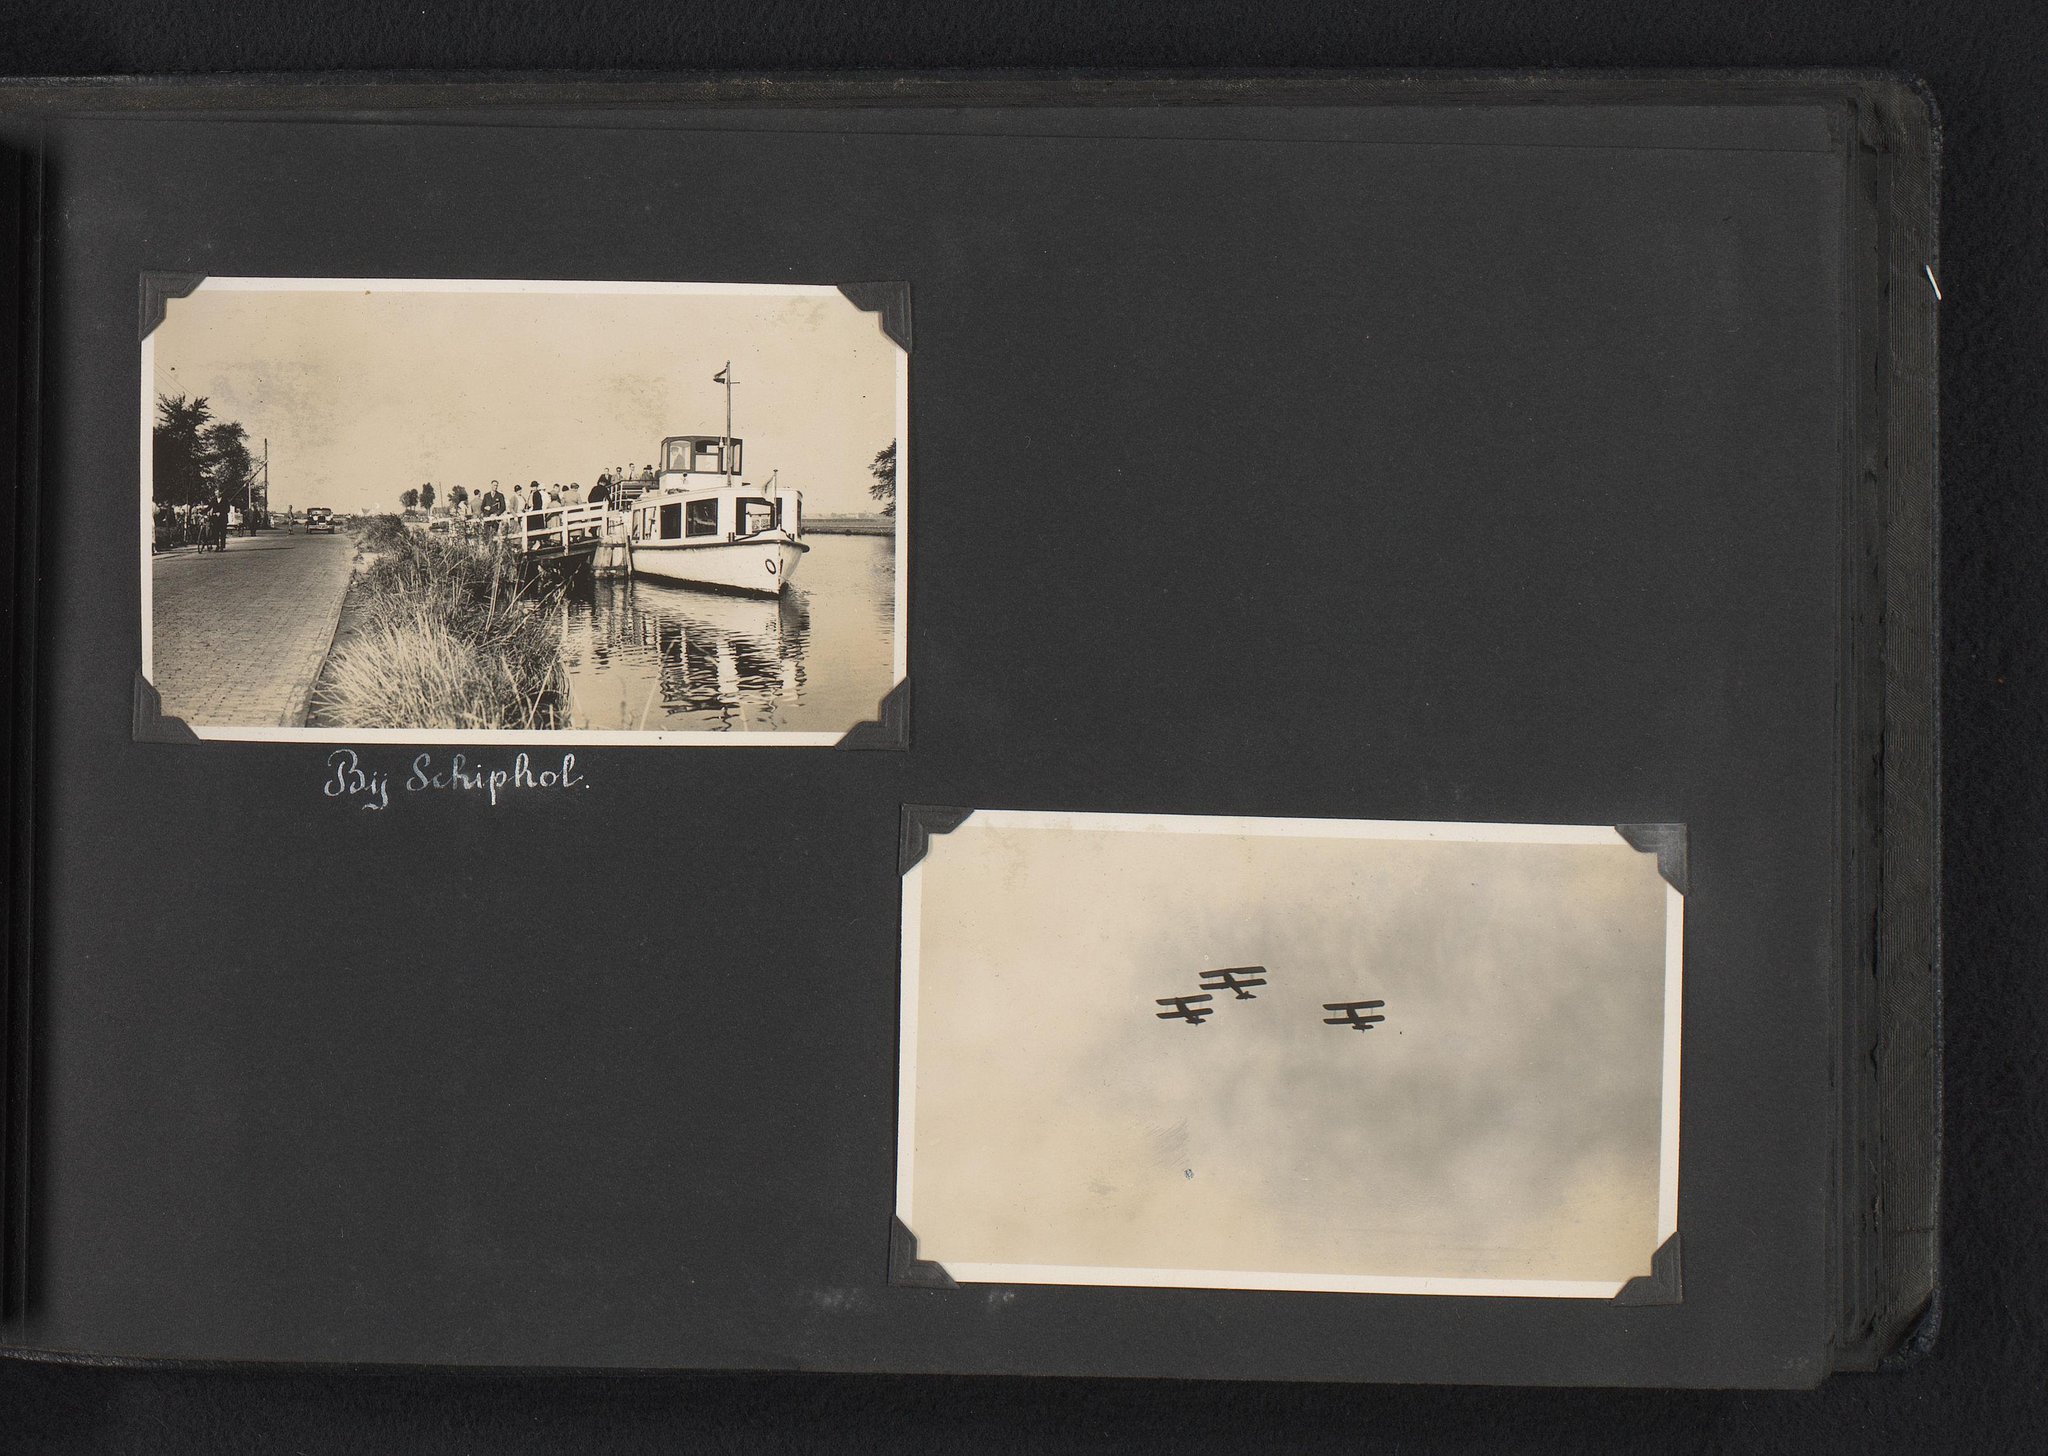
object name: album leaf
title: Twee foto's van een veerboot en vliegtuigen bij Schiphol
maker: frank willem van den berg (1912-1998)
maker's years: 1912-1998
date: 1934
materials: paper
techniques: gelatin silver print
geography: schiphol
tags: aircraft, aeroplane, ferry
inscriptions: inscription: ‘Bij Schiphol’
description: Deze foto's maken deel uit van een album.